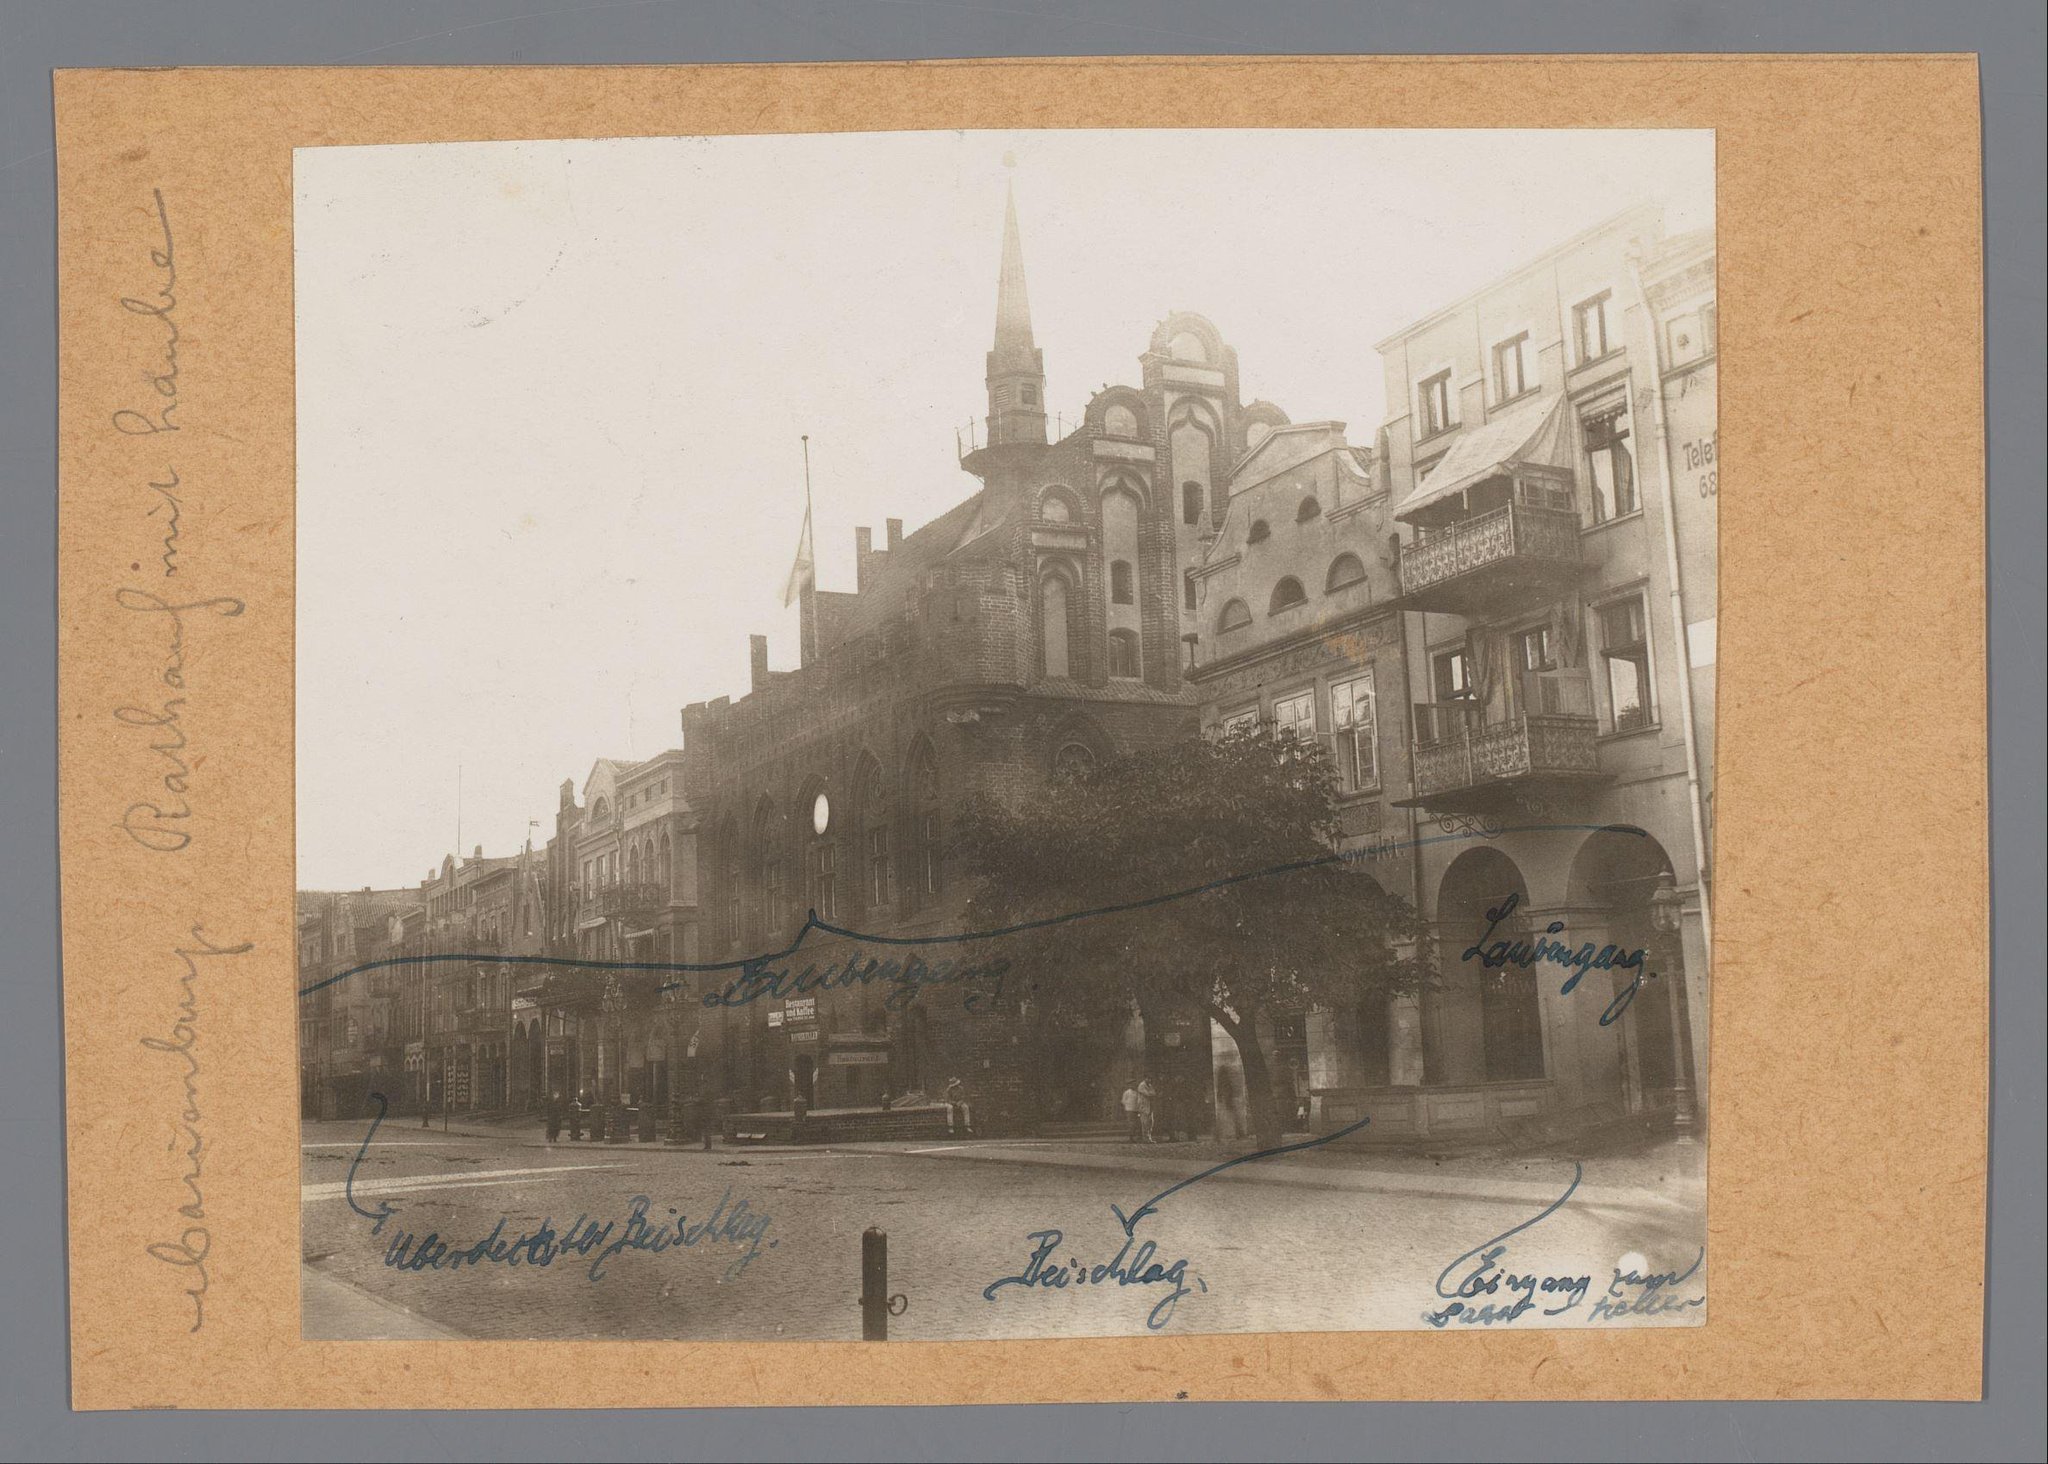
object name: photograph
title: Stadhuis van Malbork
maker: Anonymous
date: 1910-1930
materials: paper, cardboard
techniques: gelatin silver print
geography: malbork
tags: townhall